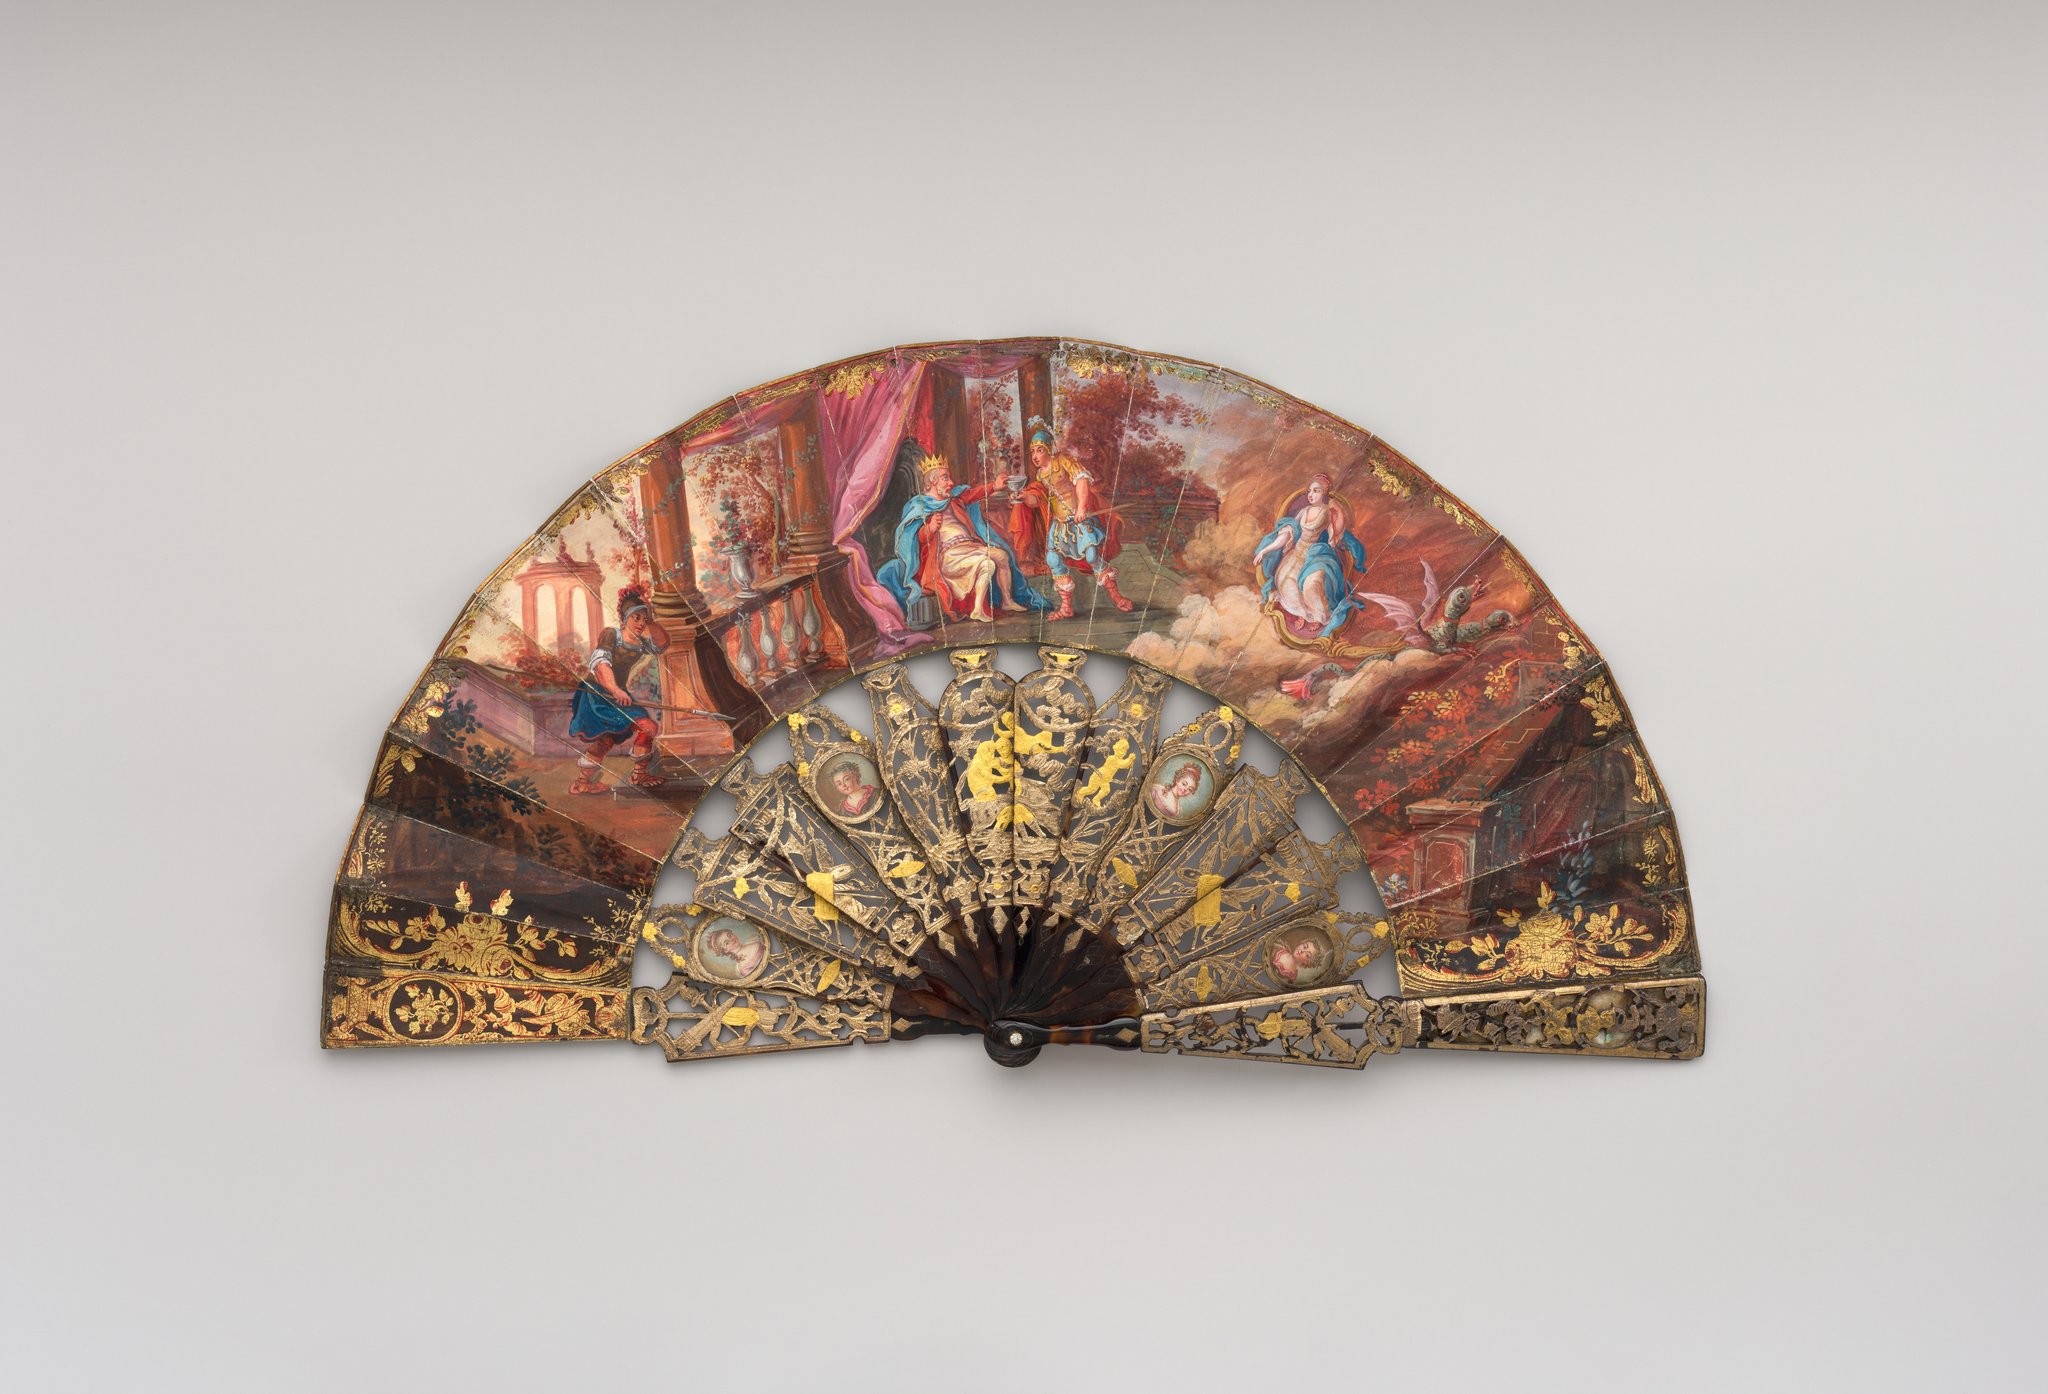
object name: fan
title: Folding fan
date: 1767-1800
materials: celluloid, gilt, glass, gold, gold leaf, paint, paper, shell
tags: men,women